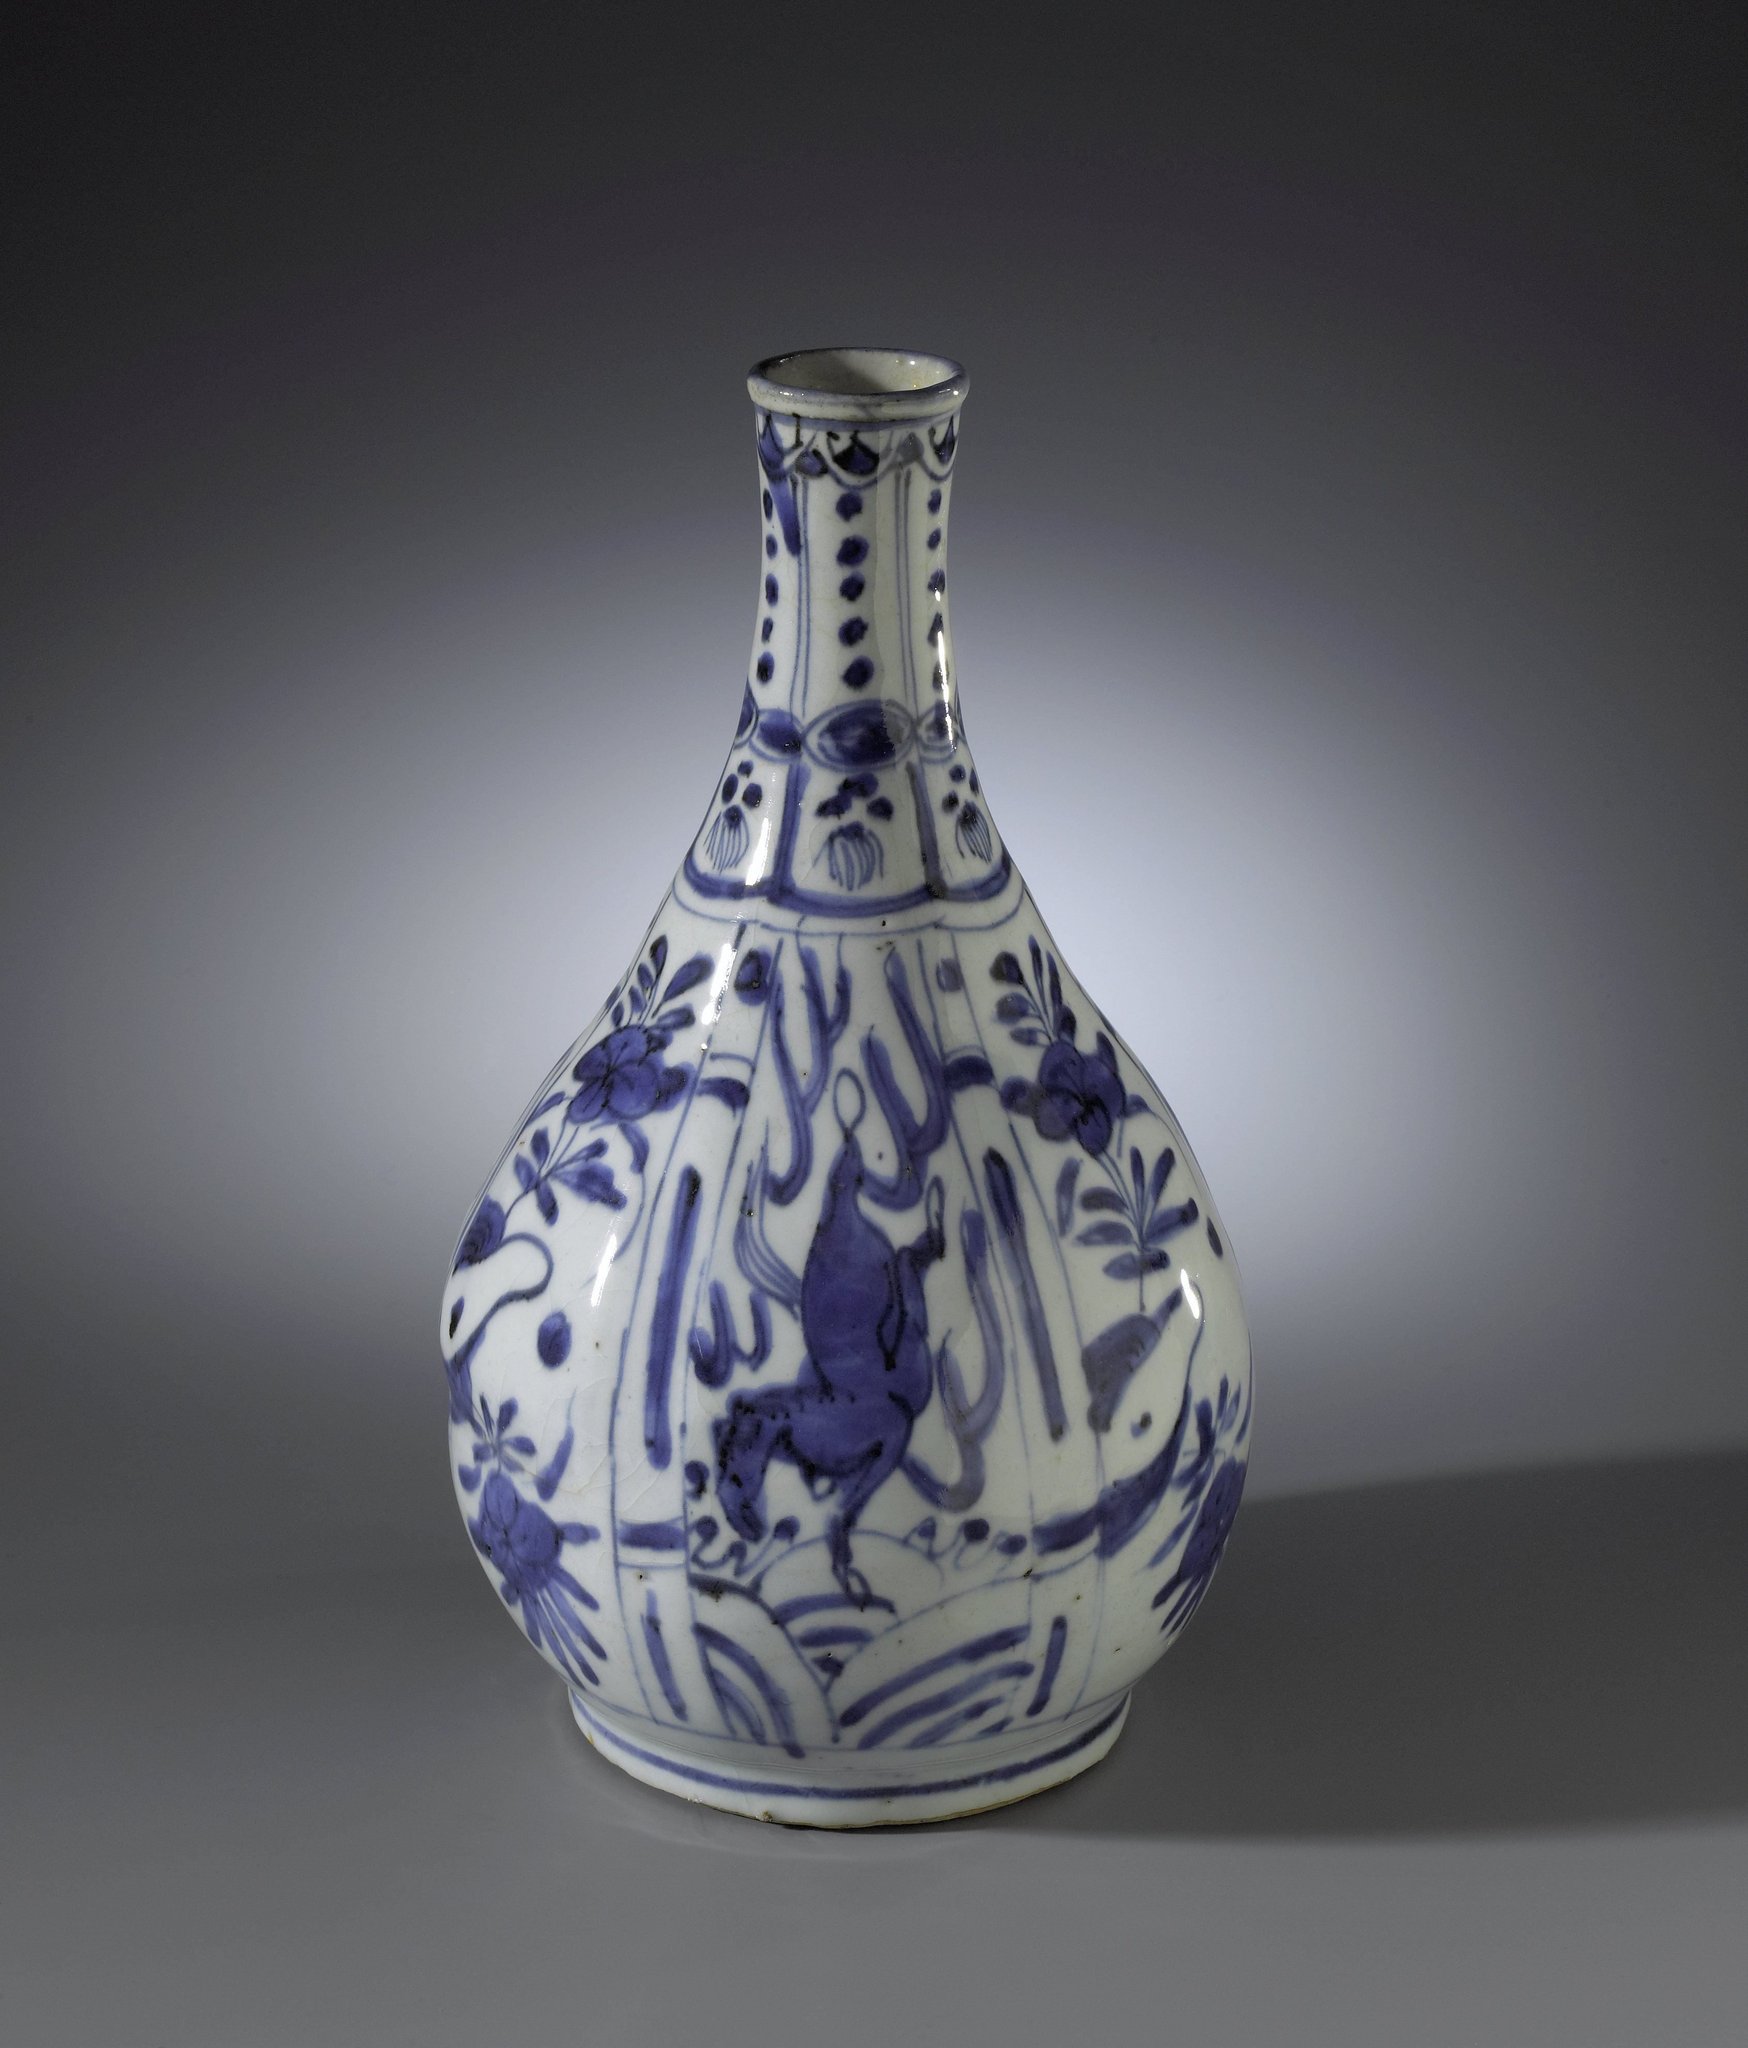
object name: vase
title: Pear-shaped bottle vase with horses and flower sprays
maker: Anonymous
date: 1600-1649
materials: cobalt, glaze, paint, porcelain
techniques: firing, turning, vitrification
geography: china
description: Flesvormige vaas van porselein met een peervormig lichaam, beschilderd in onderglazuur blauw. De wand is verdeeld in vakken met daarin afwisselend galopperende paarden en bloemtakken; op de hals een vakdecoratie met stippen en kwasten. Kraakporselein.